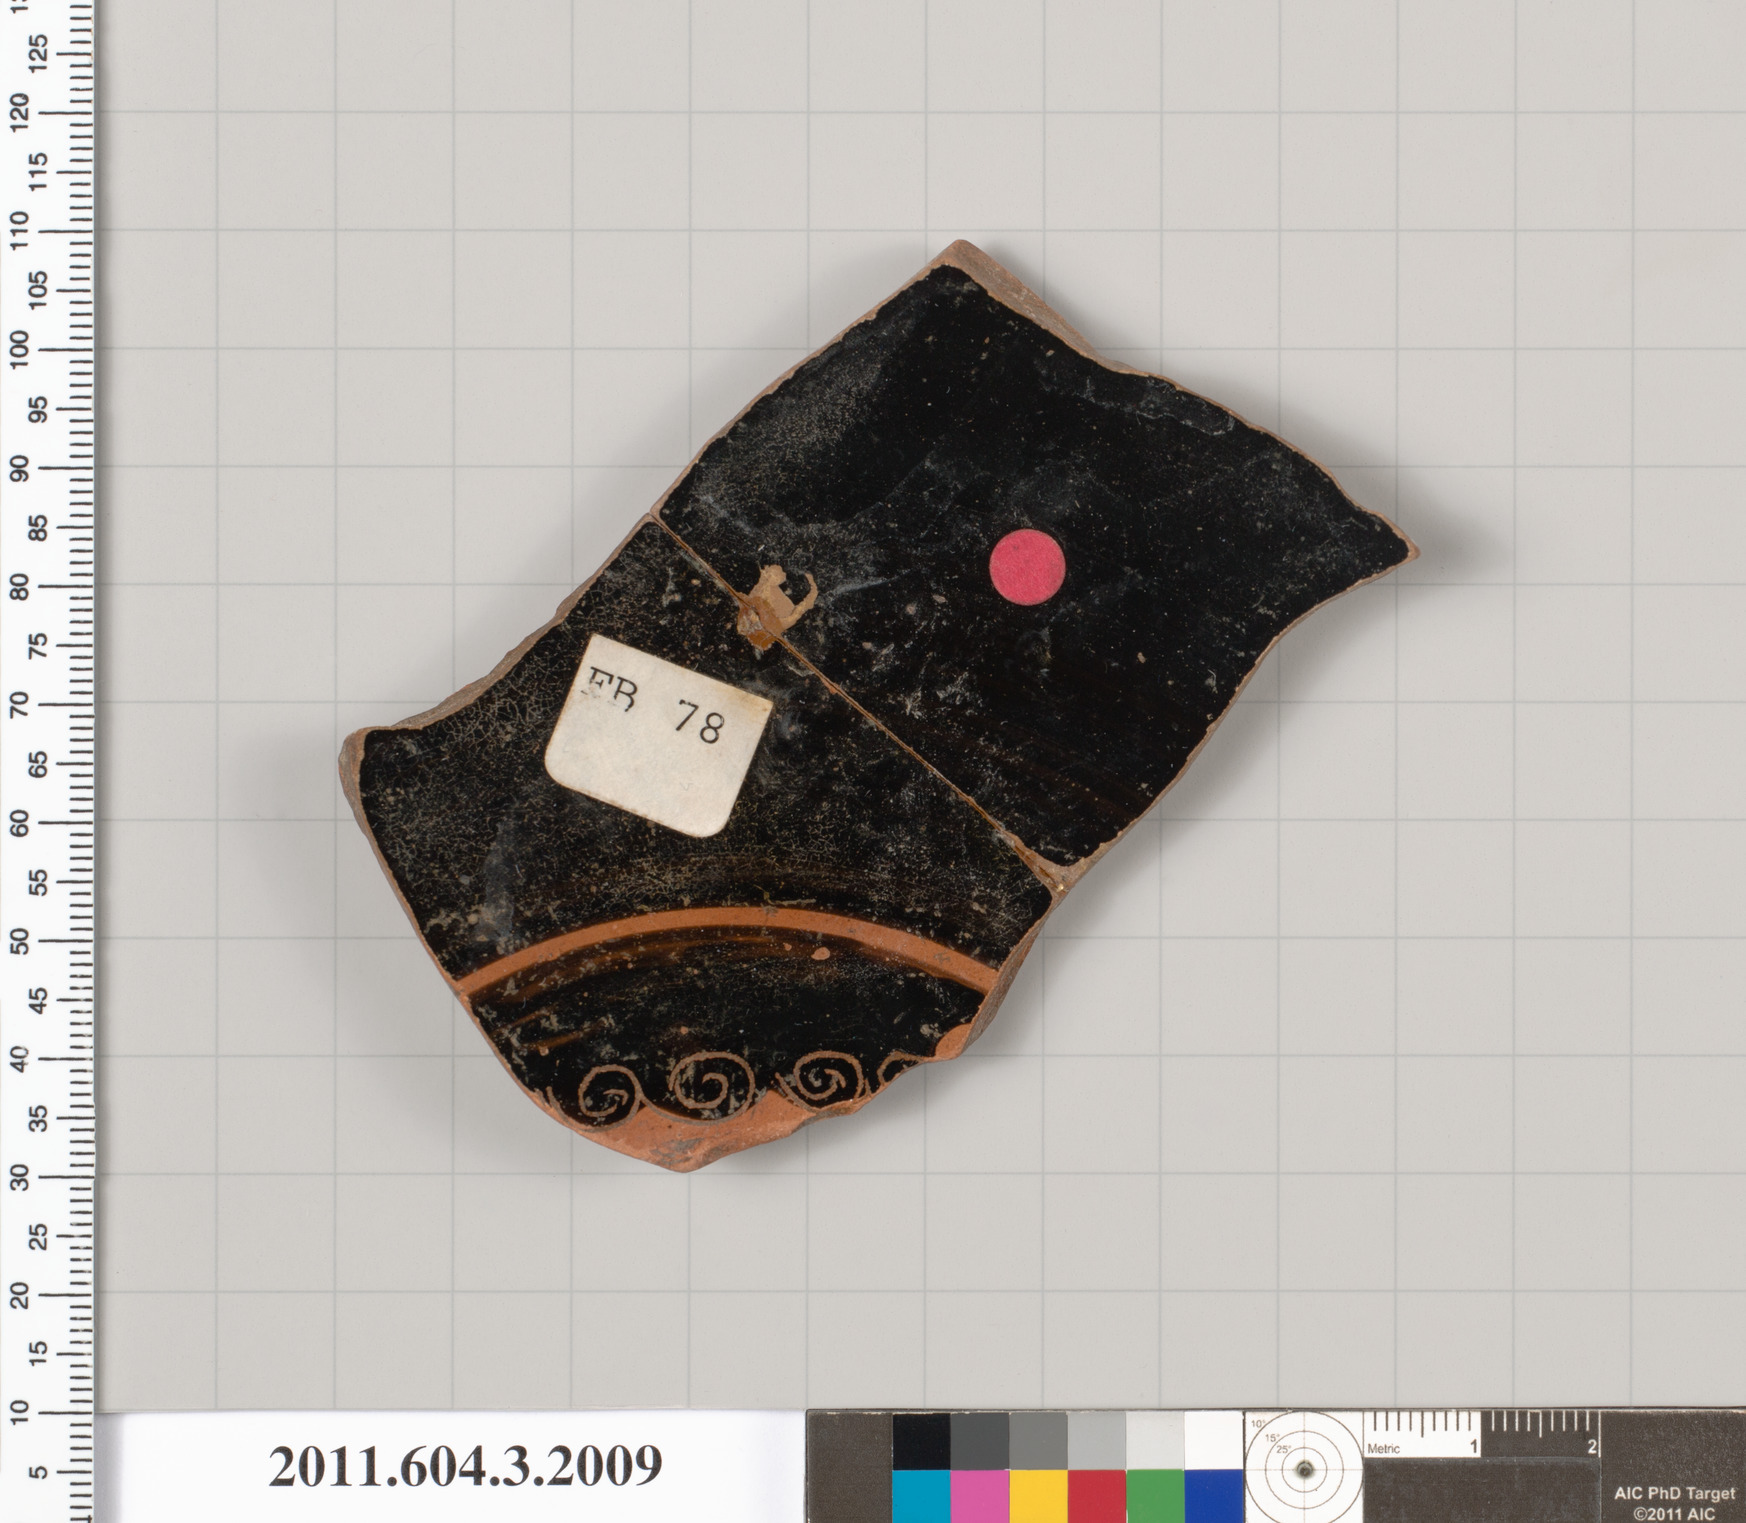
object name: kylix fragment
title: Terracotta fragment of a kylix (drinking cup)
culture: greek, attic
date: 540-530 BCE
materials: terracotta